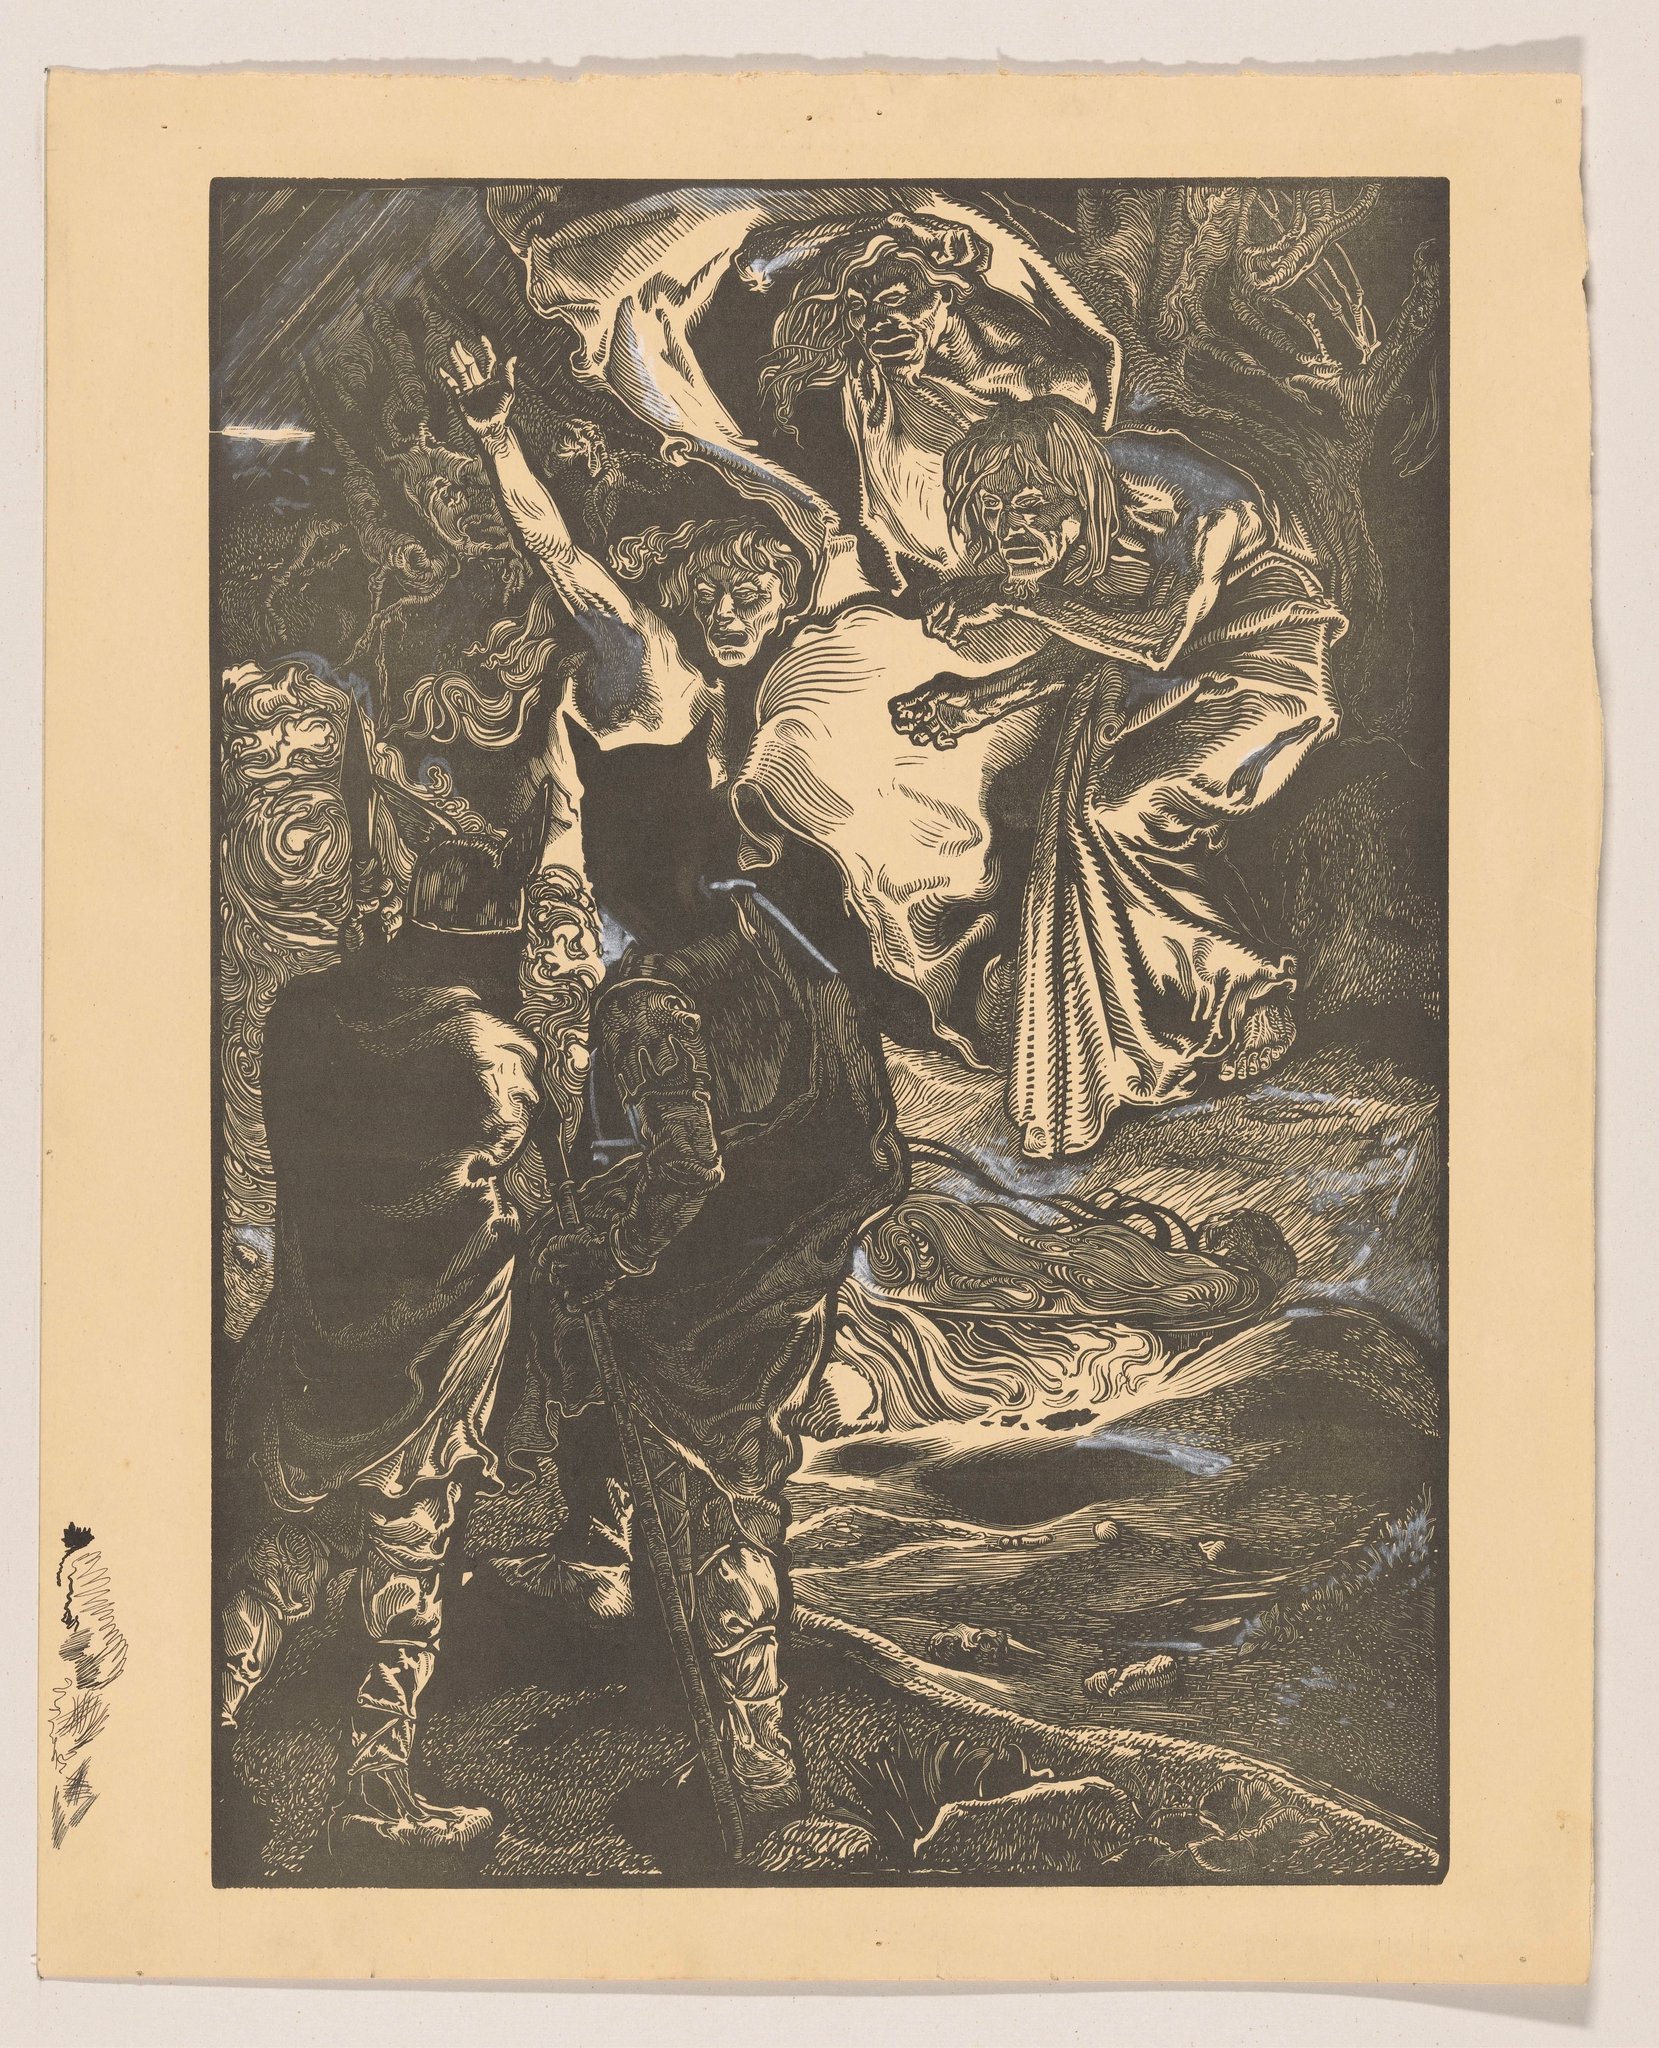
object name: print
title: Macbeth en Banquo ontmoeten de drie heksen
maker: johannes josephus aarts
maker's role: draughtsman, print maker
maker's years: 1871-1934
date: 1881-1934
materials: paper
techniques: woodcut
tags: groups of witches, macbeth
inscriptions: collector's mark: Lugt 2166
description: Linksonder Macbeth en zijn vriend Banquo, rechtsboven de drie heksen die voor elk van hen voorspellingen in petto hebben.